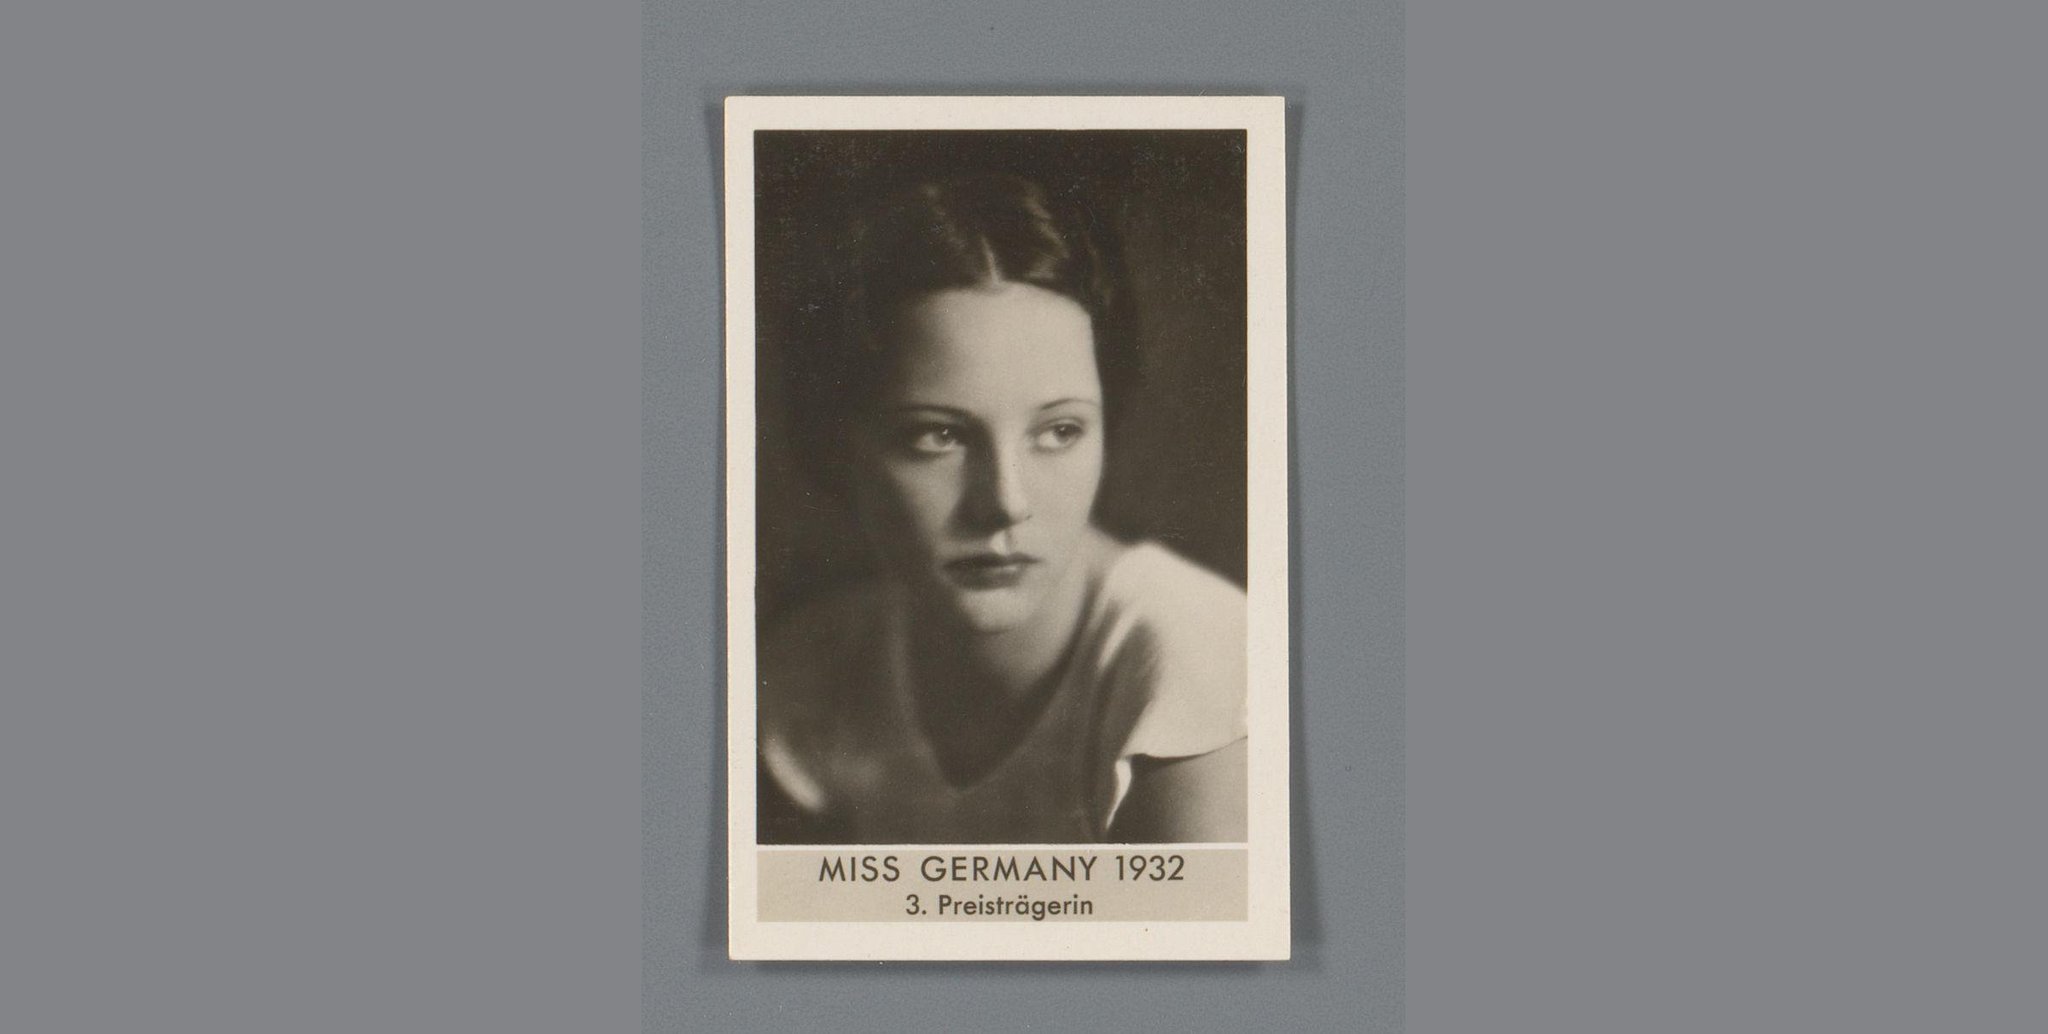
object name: photograph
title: Miss Germany 1932, 3. Preisträgerin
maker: Anonymous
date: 1932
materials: paper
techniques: gelatin silver print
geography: dresden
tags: anonymous historical person portrayed - bb - woman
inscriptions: inscription: ‘Die schönsten/ Frauen der Welt/ dargestellt durch die Schön-/ heitsköniginnen aller Länder,/ finden Sie in 190 echten/ Bromsilber-Fotos, die nur den/ CLUB-und-LIGA-Packun-/ gen beiliegen. Eind prächtiges/ Sammel-Album erhalten Sie/ für 75 Pfennig vom Händler/ oder bei Einsendung von/ 75 Pfennig in Briefmarken/ von der Bilderstelle Lohse,/ Dresden A24, Nossener Str. 1./ Ges. gesch. Nachdruck verboten!’